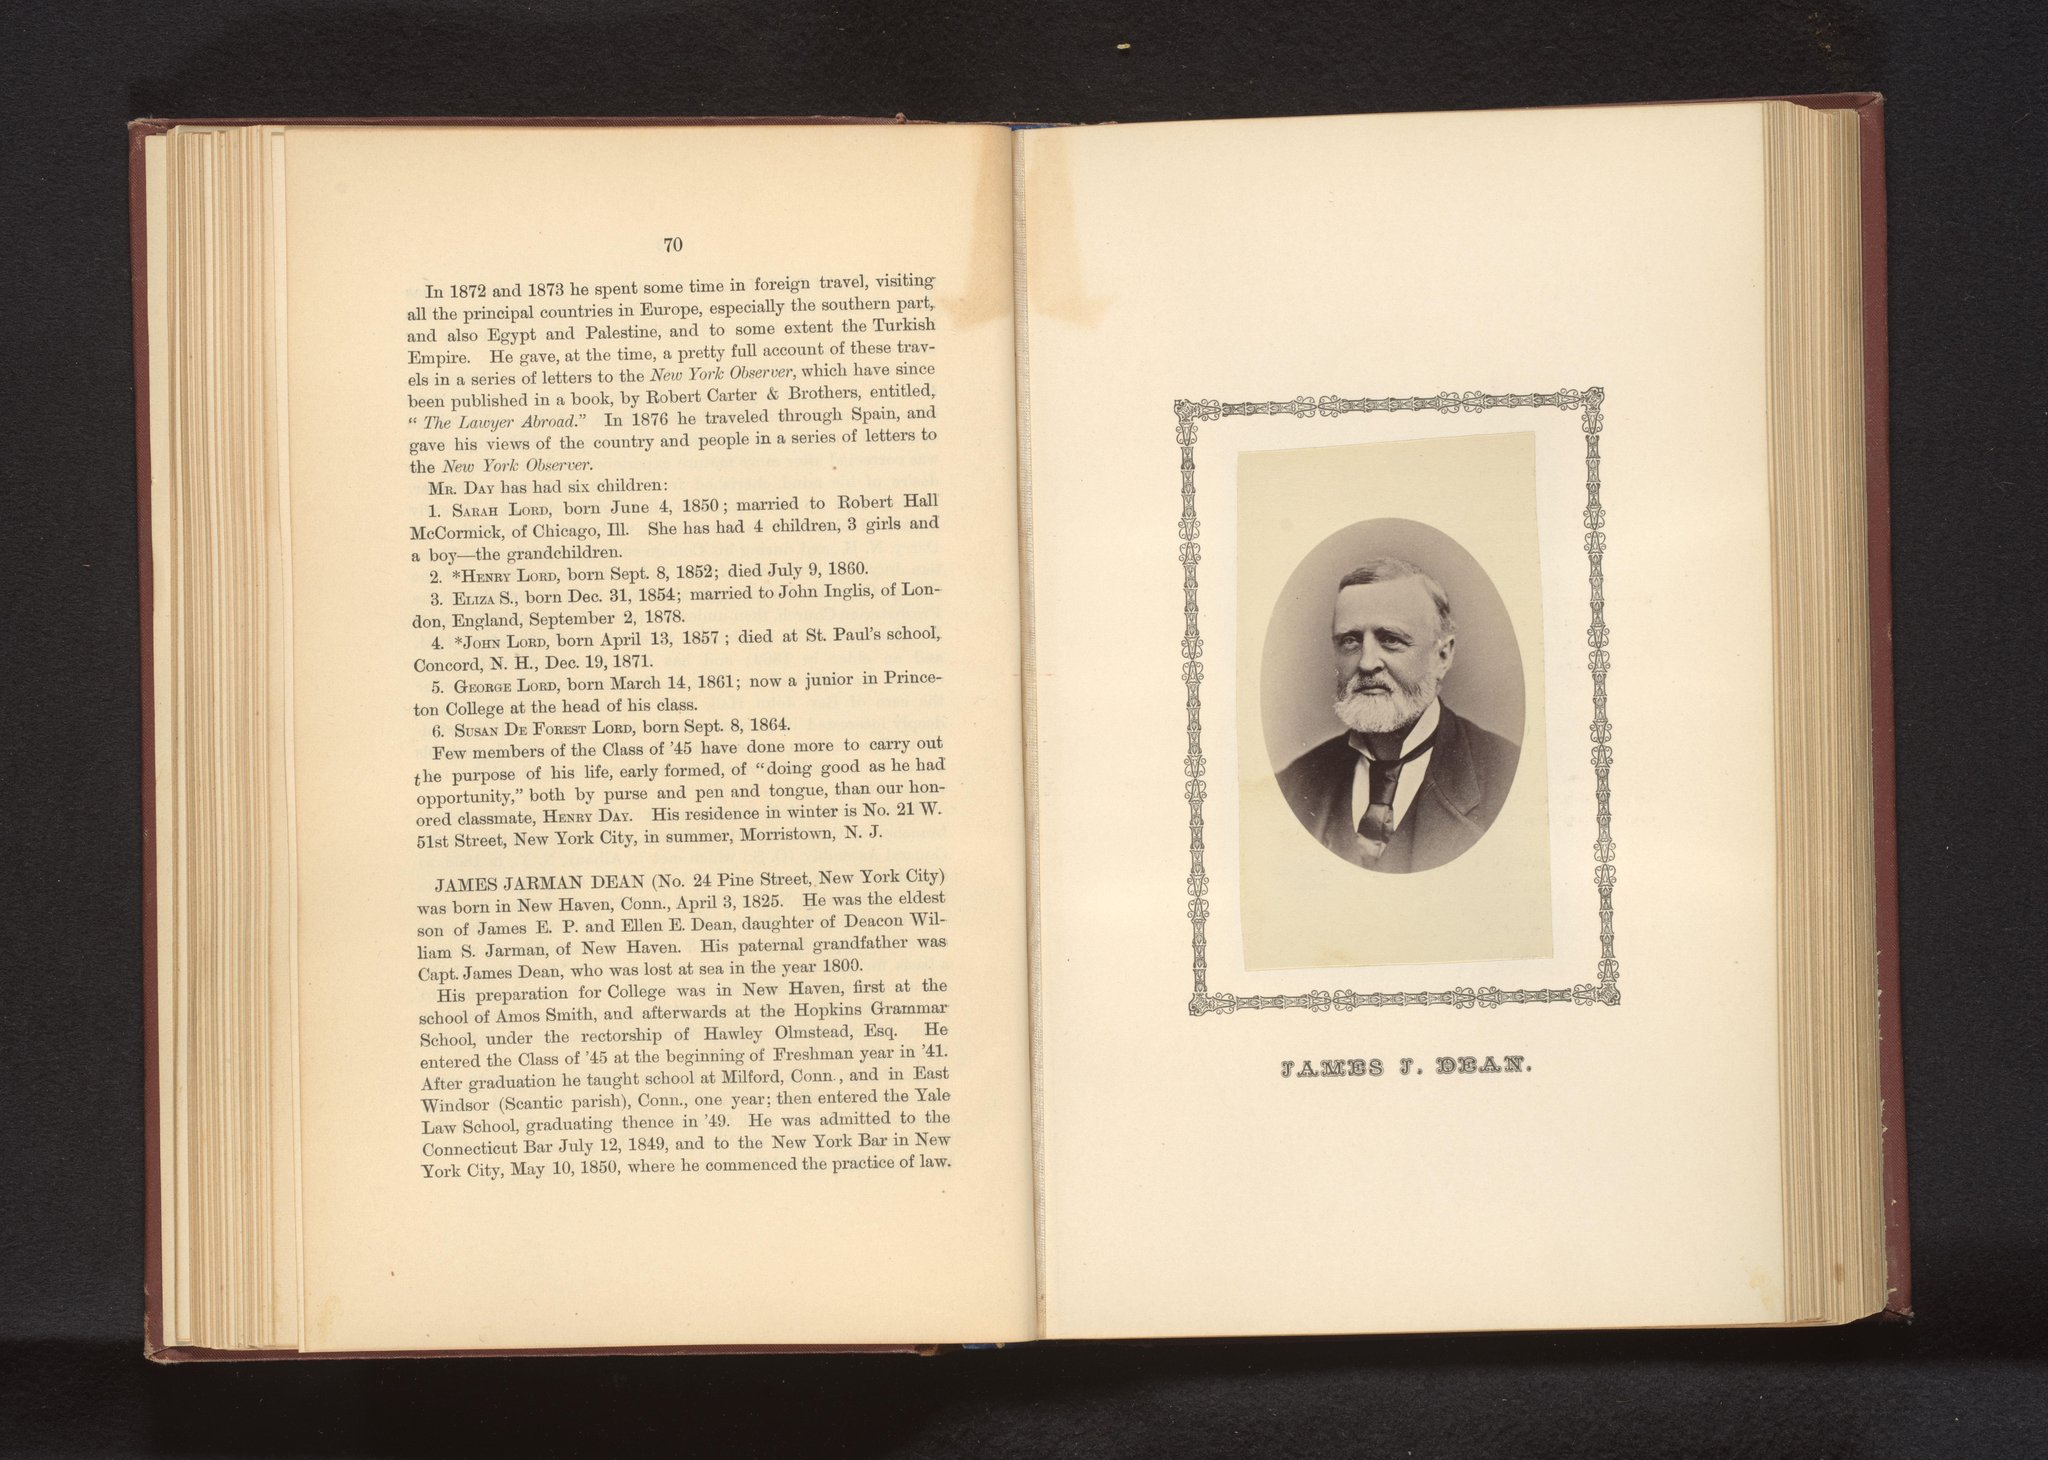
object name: photograph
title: James J. Dean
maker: Anonymous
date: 1876-1881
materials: photographic support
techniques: albumen print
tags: adult man